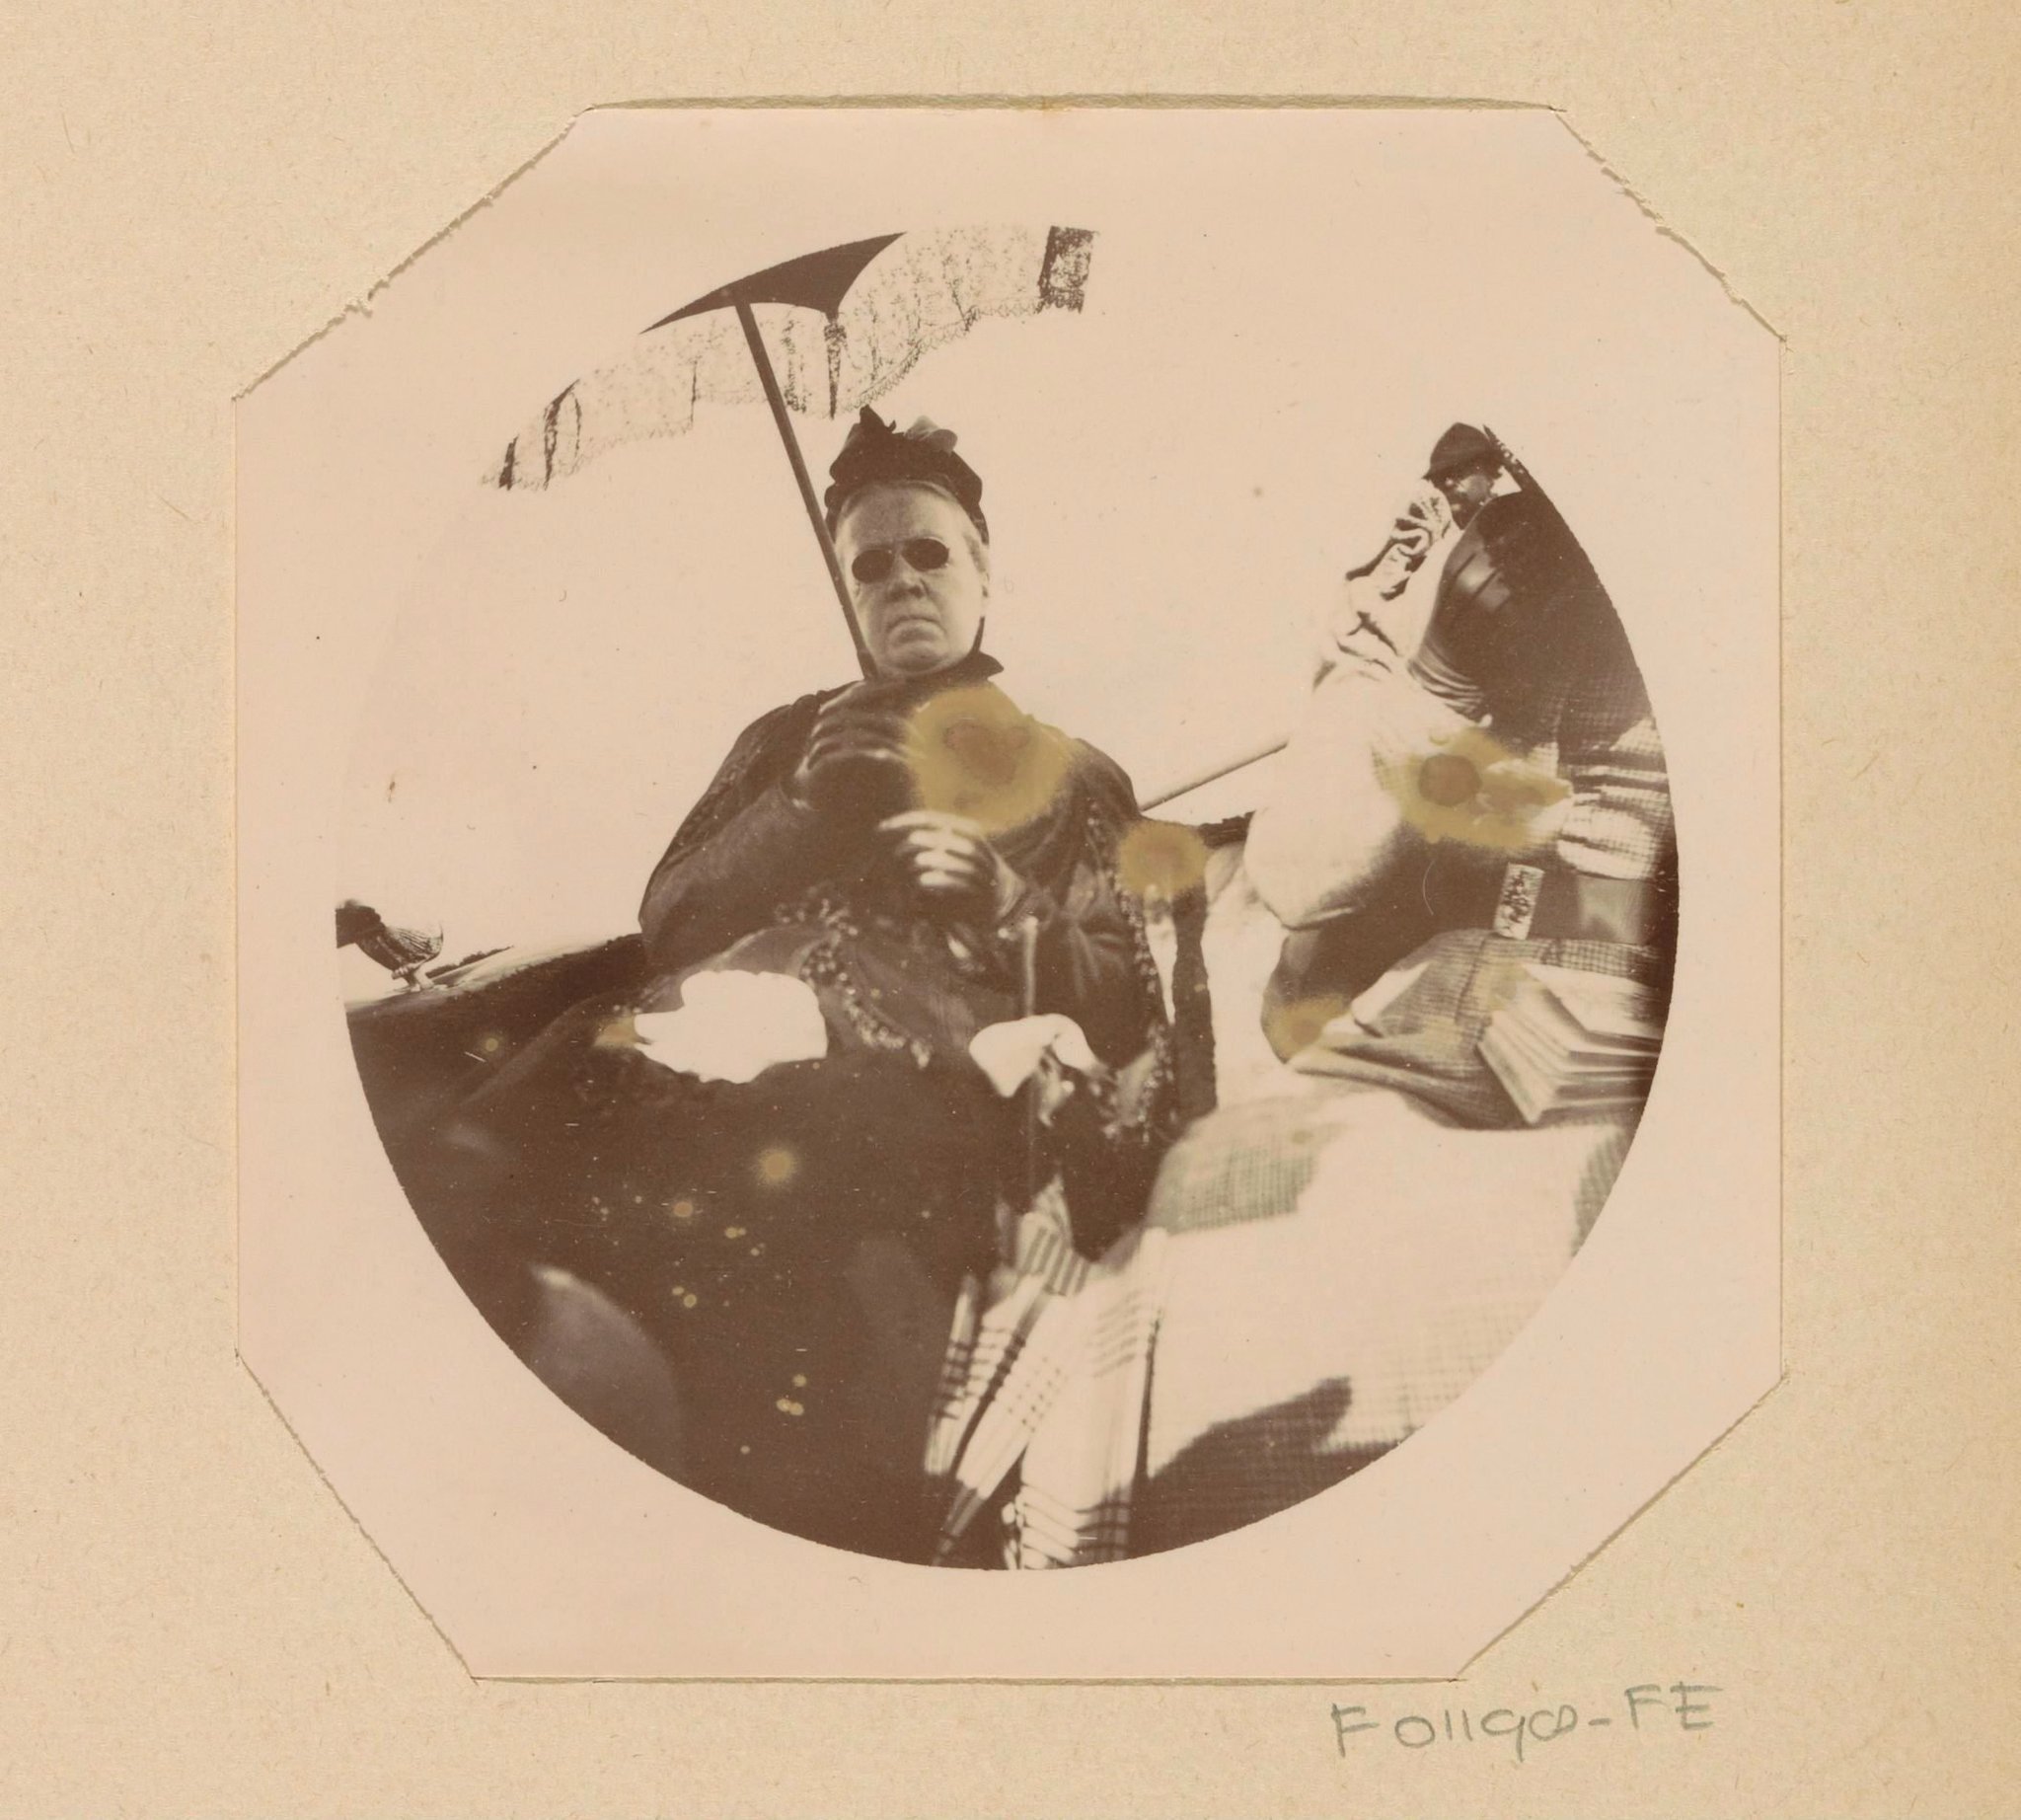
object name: album leaf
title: Portret van Lucia Wilhelmina Piek-Jolles naast een onbekende vrouw in een gondel in Venetië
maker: johanna margaretha piek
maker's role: fotograaf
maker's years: 1870-1947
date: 1889-1893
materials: paper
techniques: gelatin silver print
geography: venice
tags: amsterdam, historical persons, gondola, venice